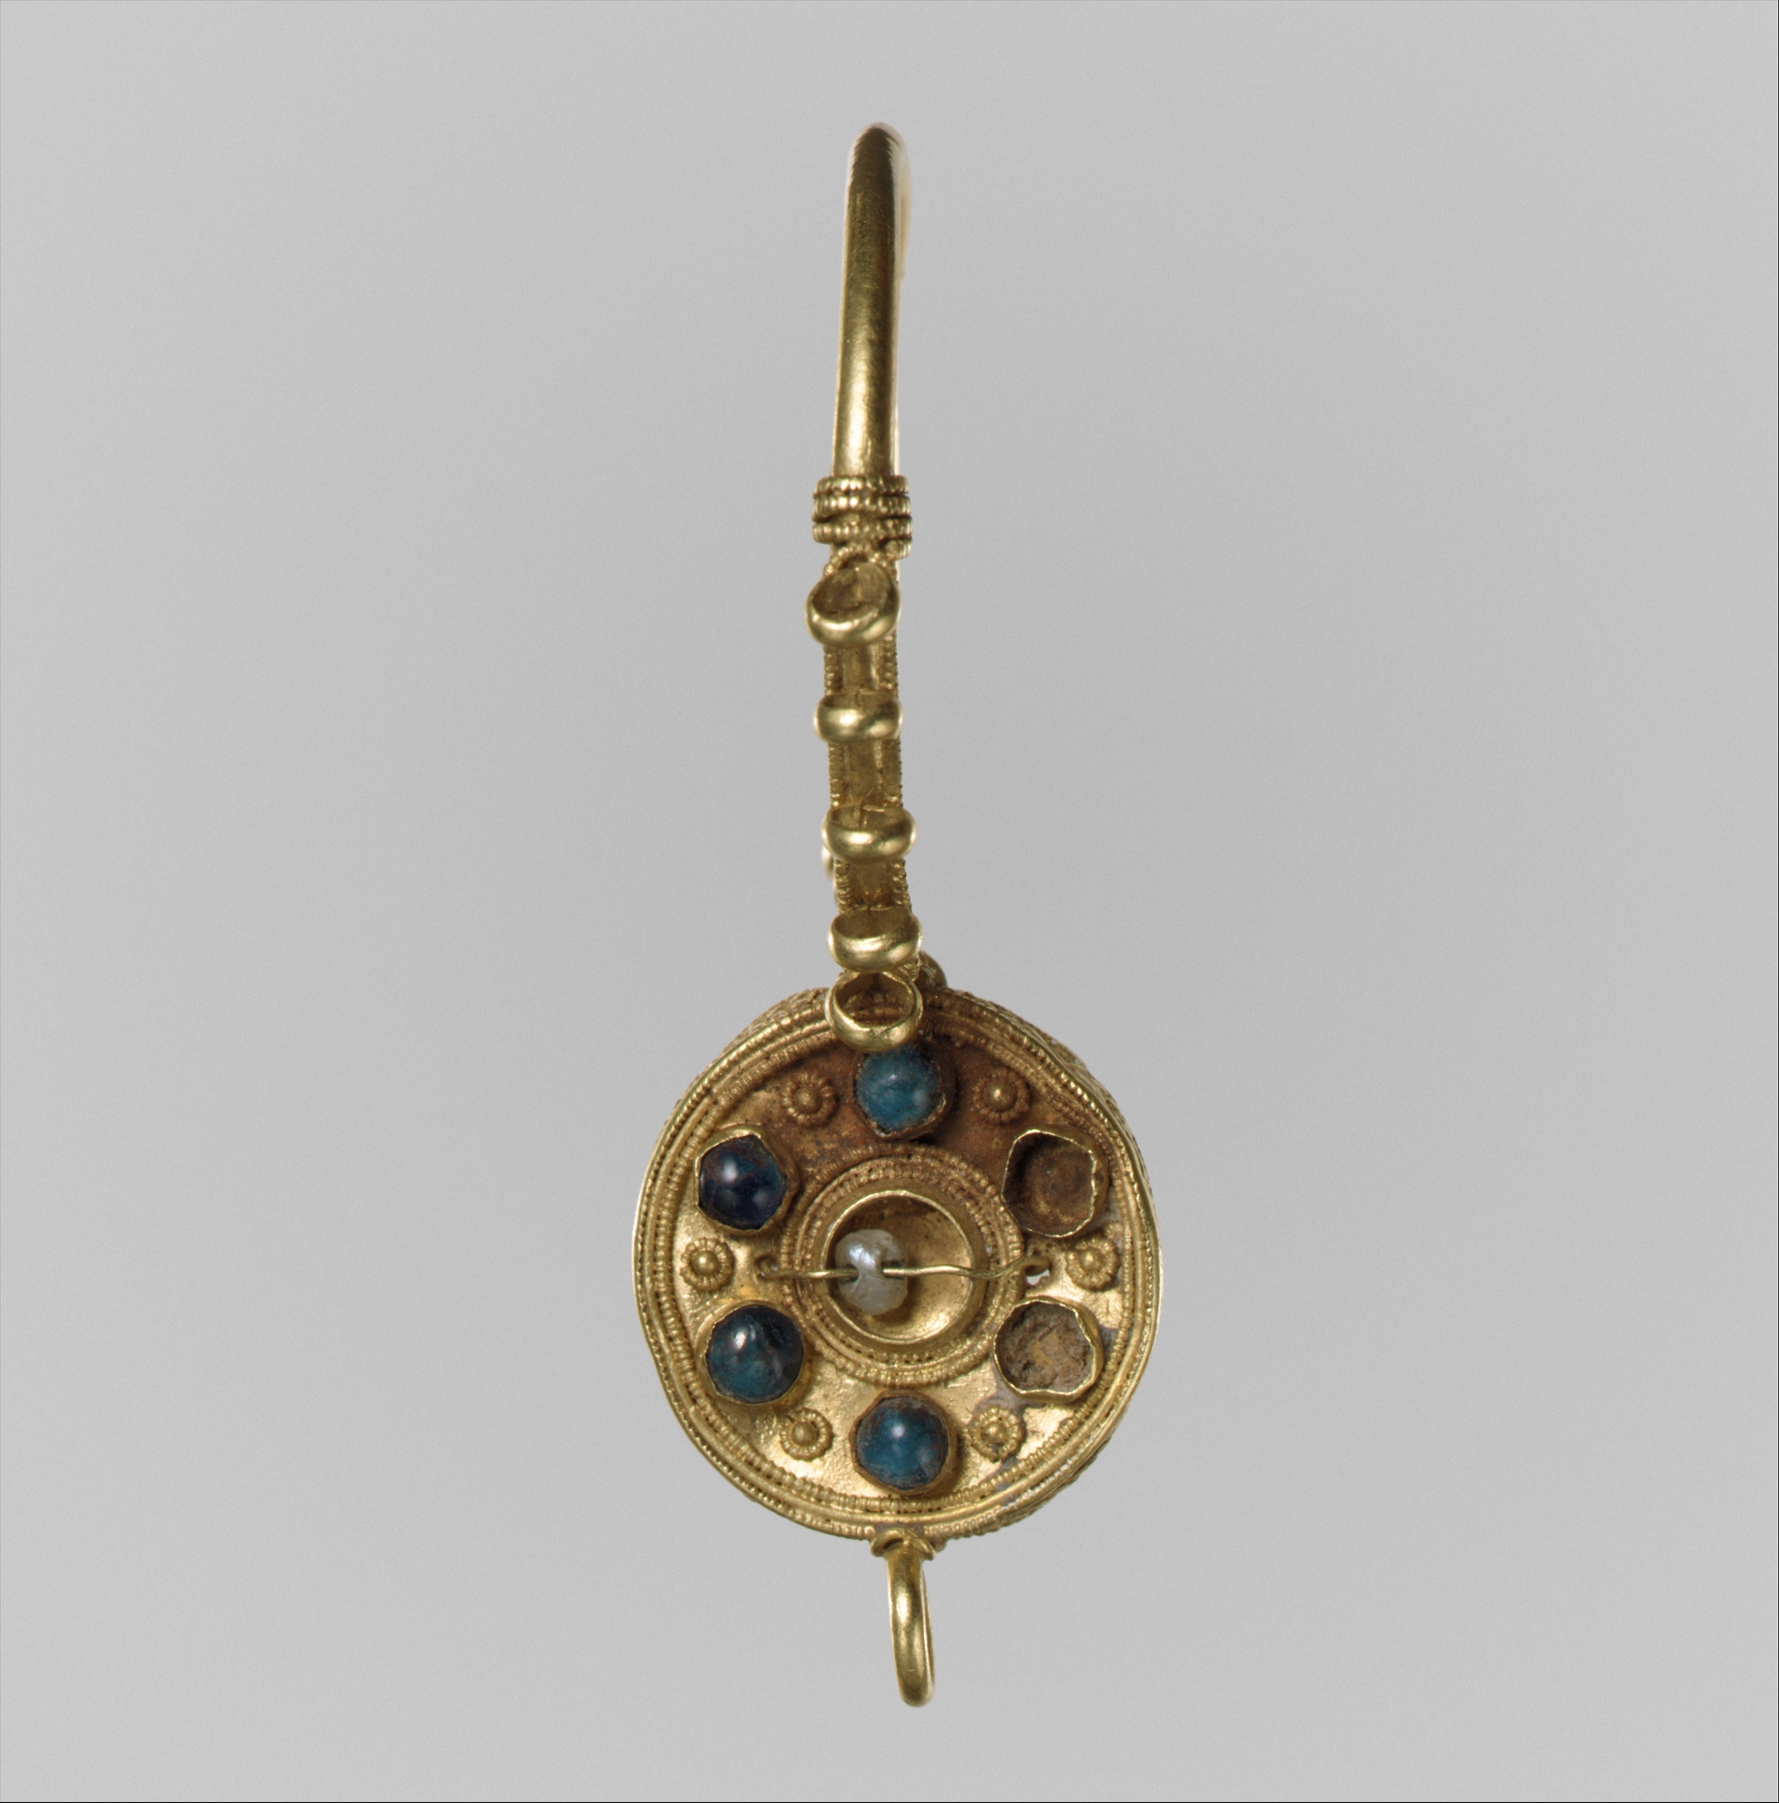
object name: earring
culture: byzantine or langobardic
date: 501-700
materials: glass, gold, pearl